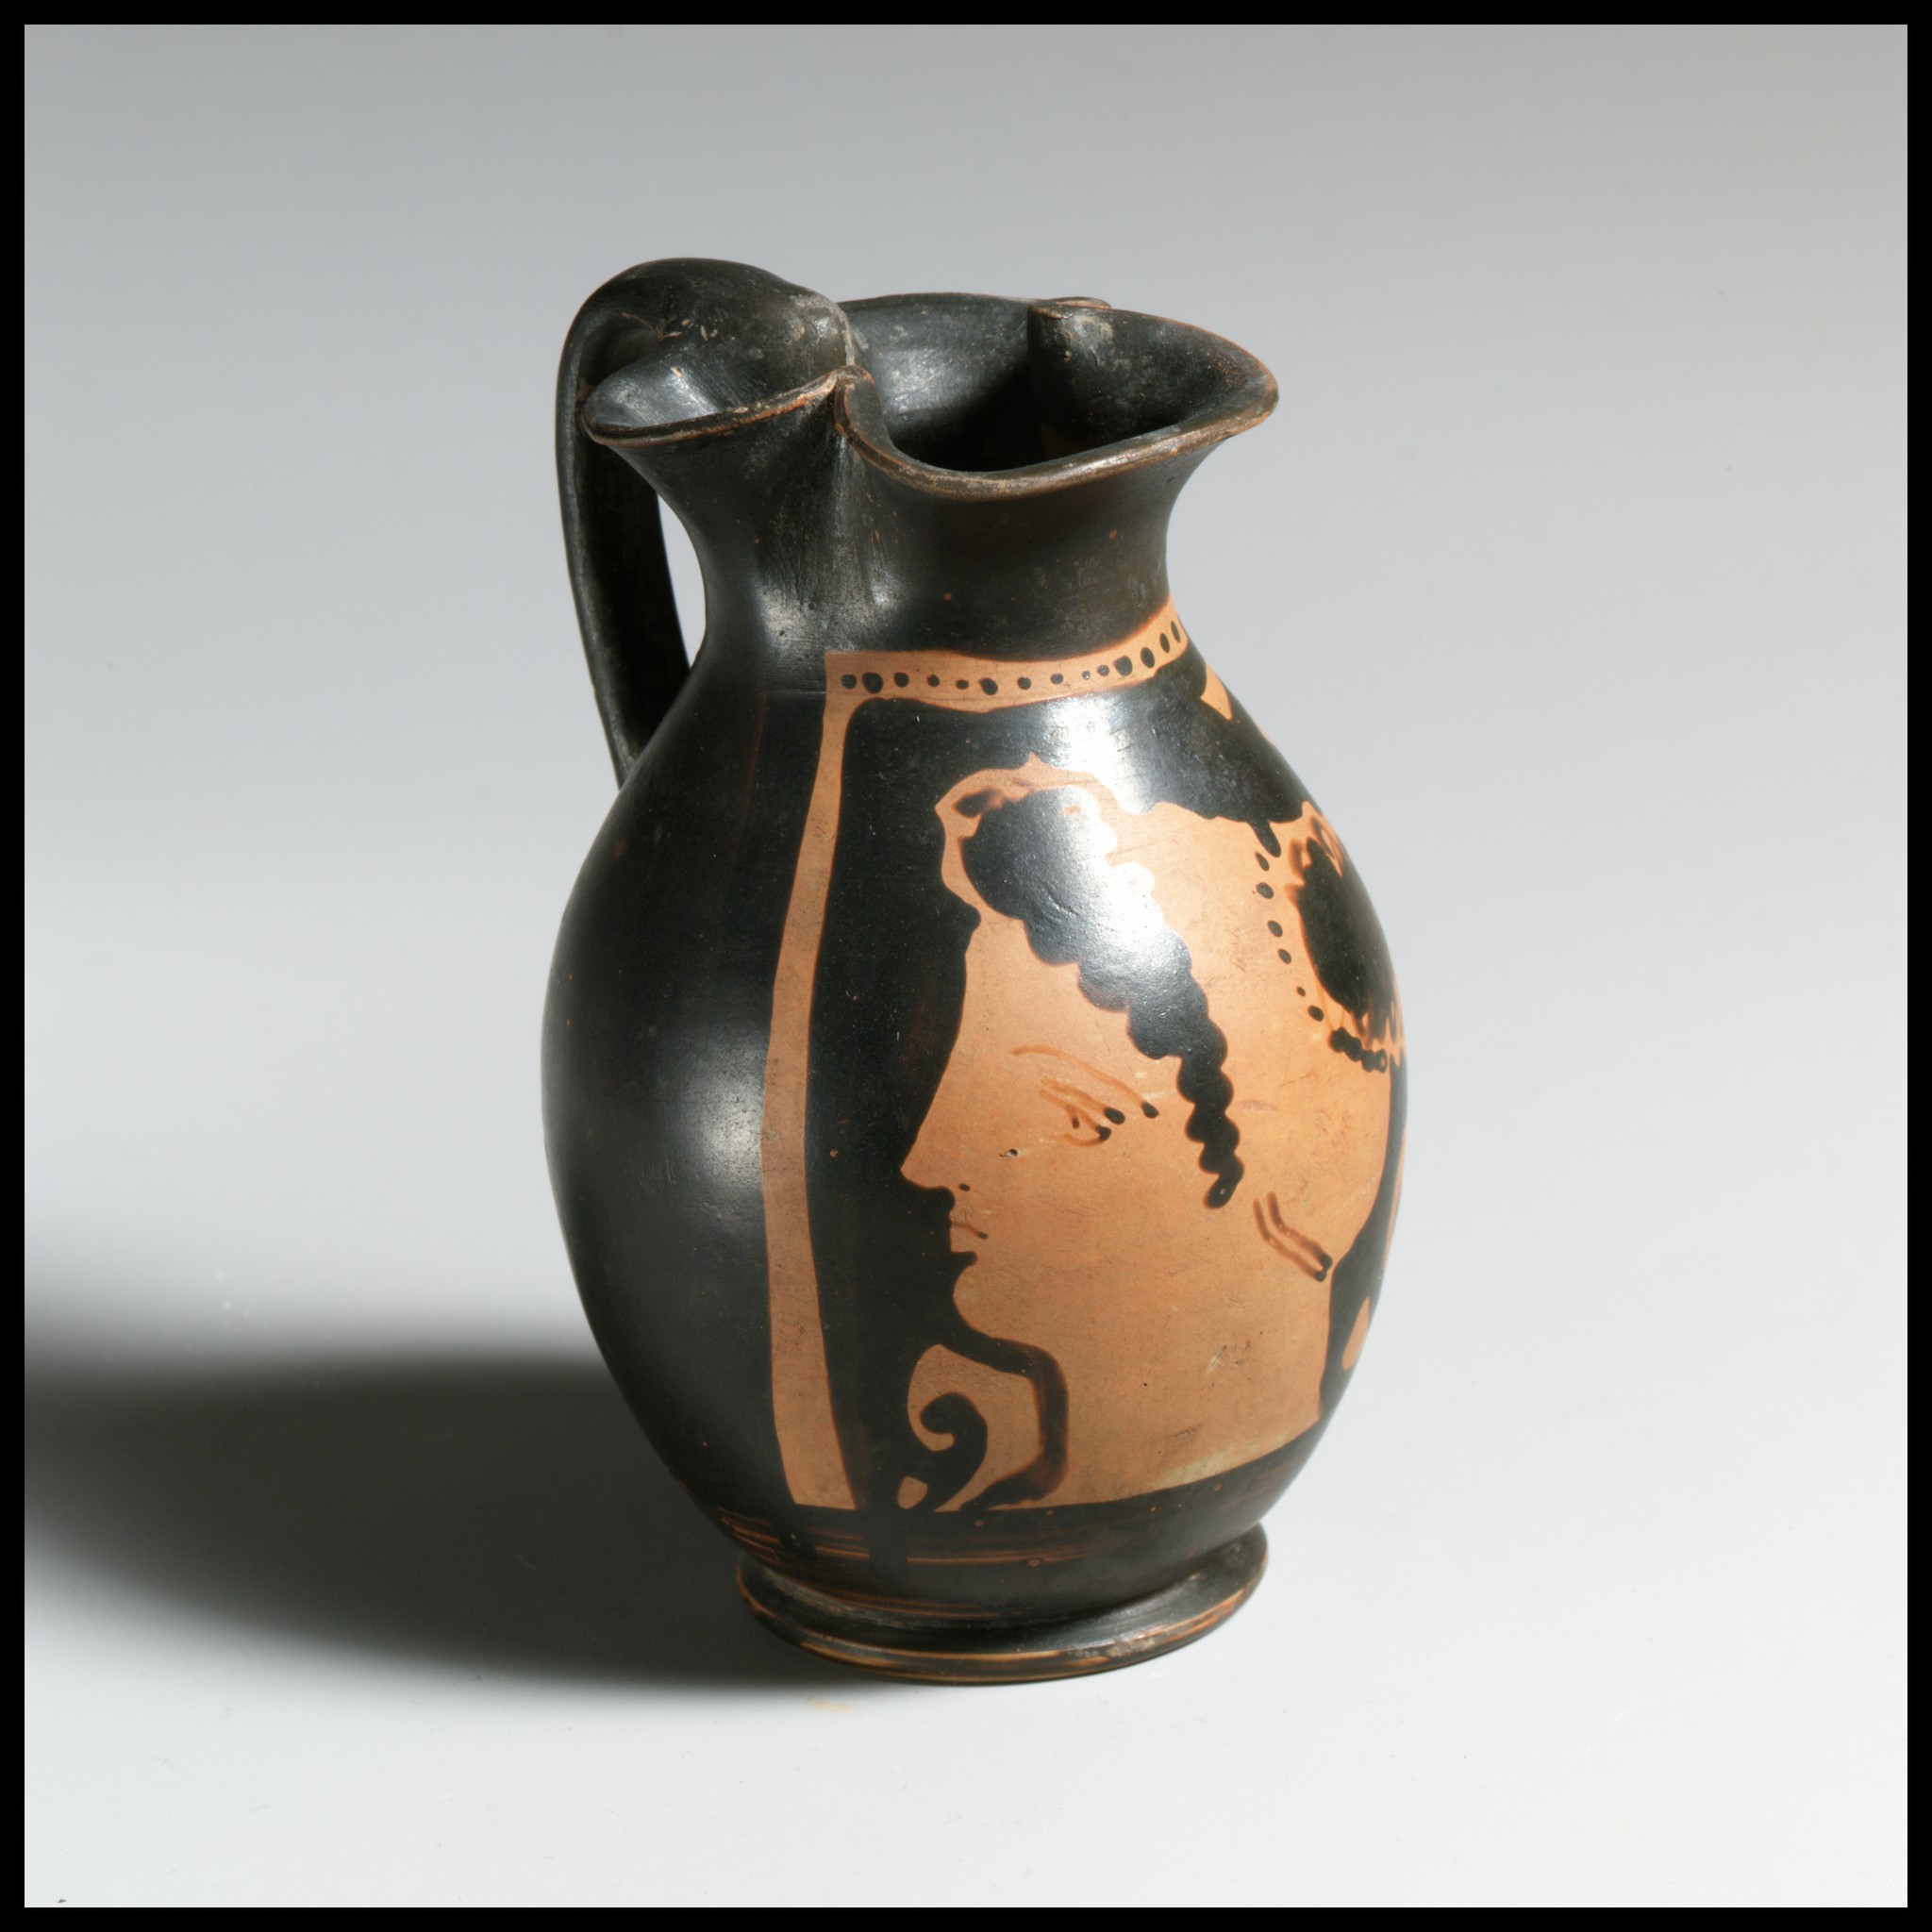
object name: oinochoe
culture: greek, south italian, apulian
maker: ugento painter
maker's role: artist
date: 350-325 BCE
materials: terracotta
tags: women